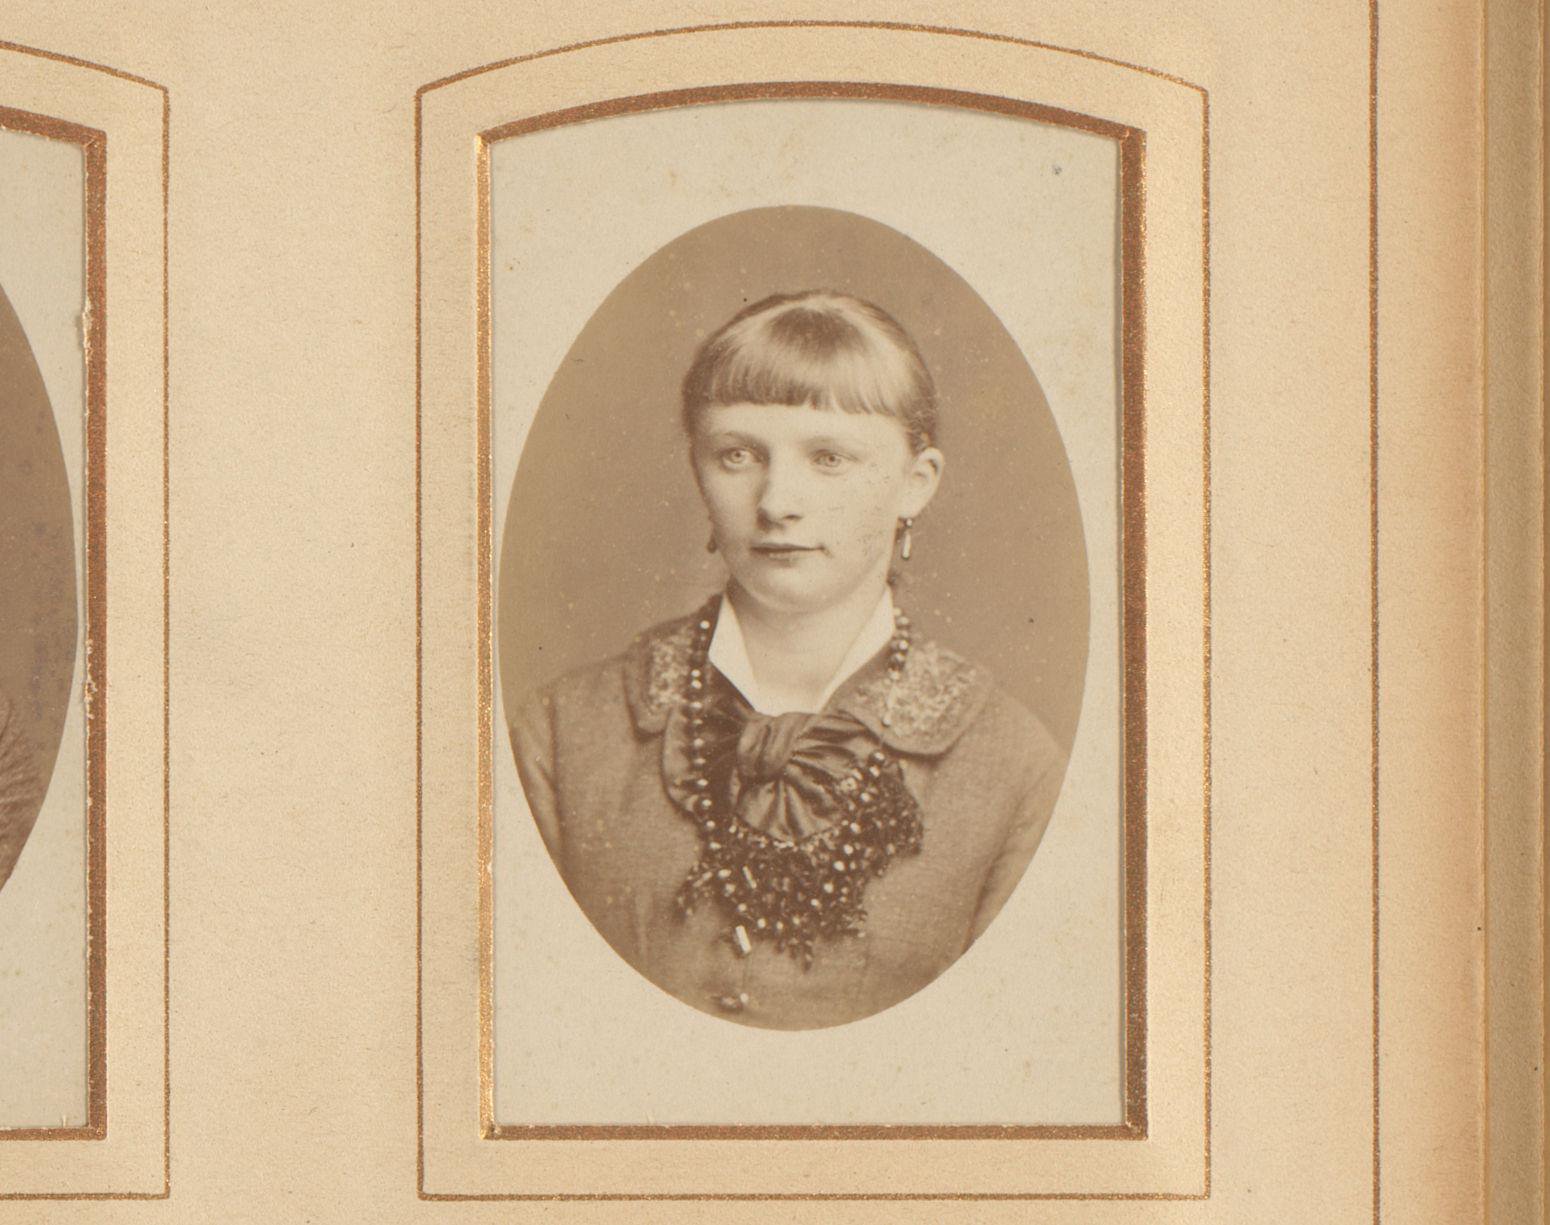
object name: carte de visite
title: Portret van een meisje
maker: Anonymous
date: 1870-1900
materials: cardboard, photographic support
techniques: albumen print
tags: historical persons - bb - woman, girl (child between toddler and youth)